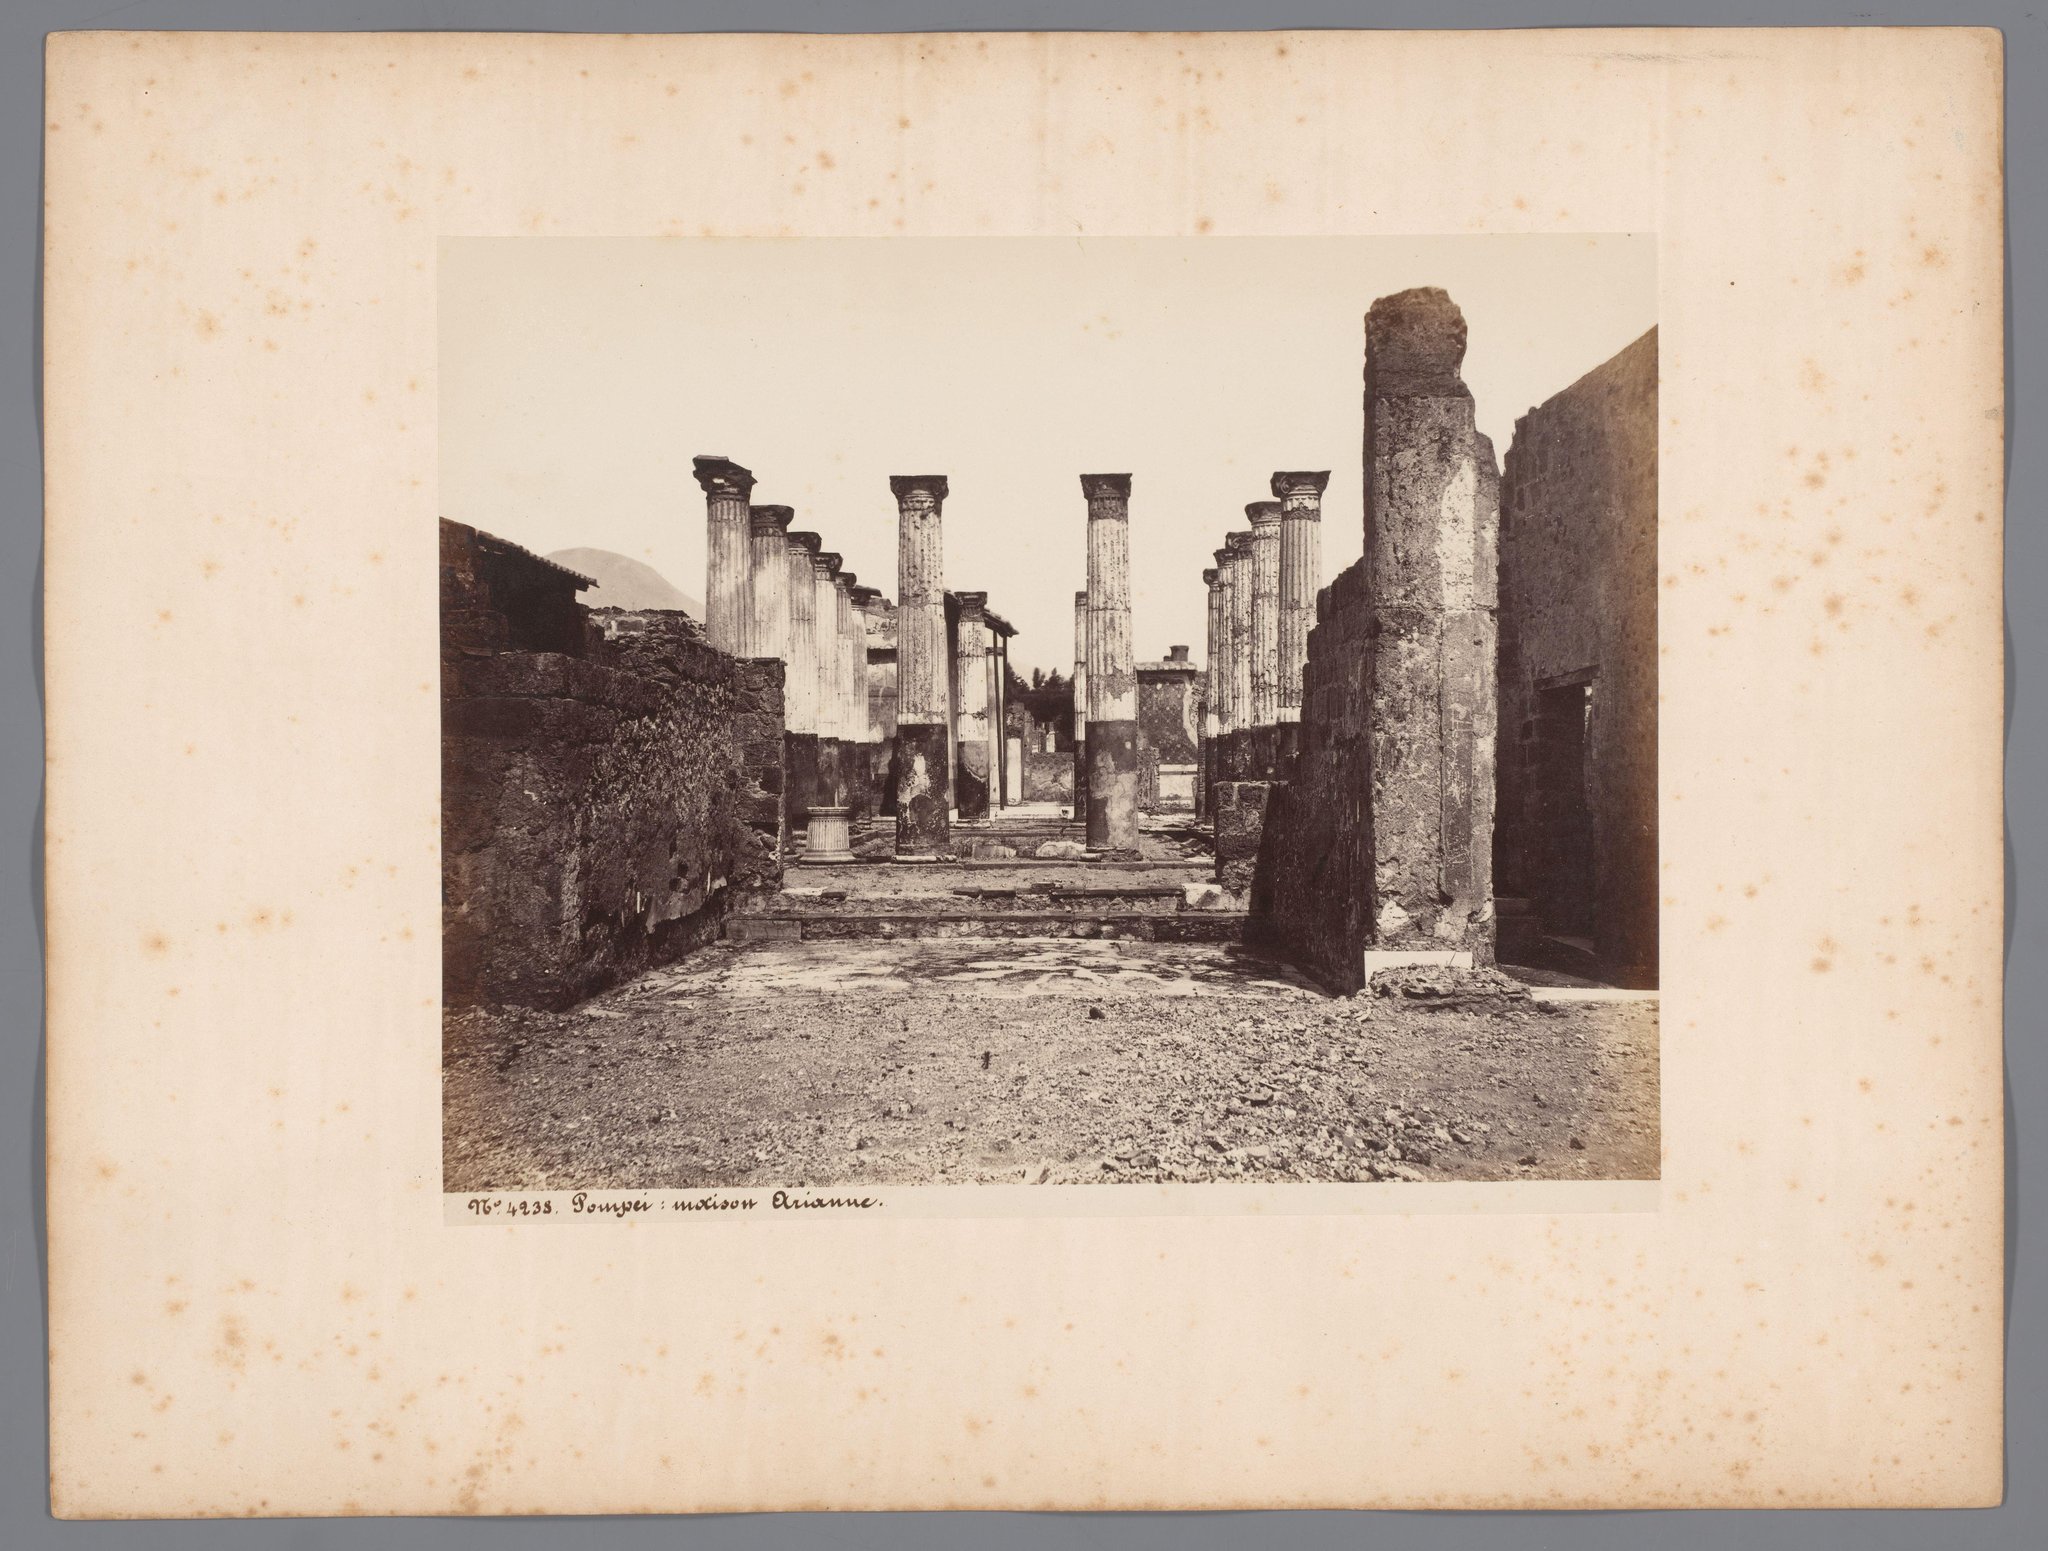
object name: photograph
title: Pompei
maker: giorgio sommer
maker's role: fotograaf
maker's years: 1834-1914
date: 1857-1875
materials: cardboard, paper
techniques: albumen print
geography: pompeii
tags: ruin of a dwelling, house, castle, etc., pompeii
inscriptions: number: ‘11’, number: ‘No 4238’, number: ‘59’